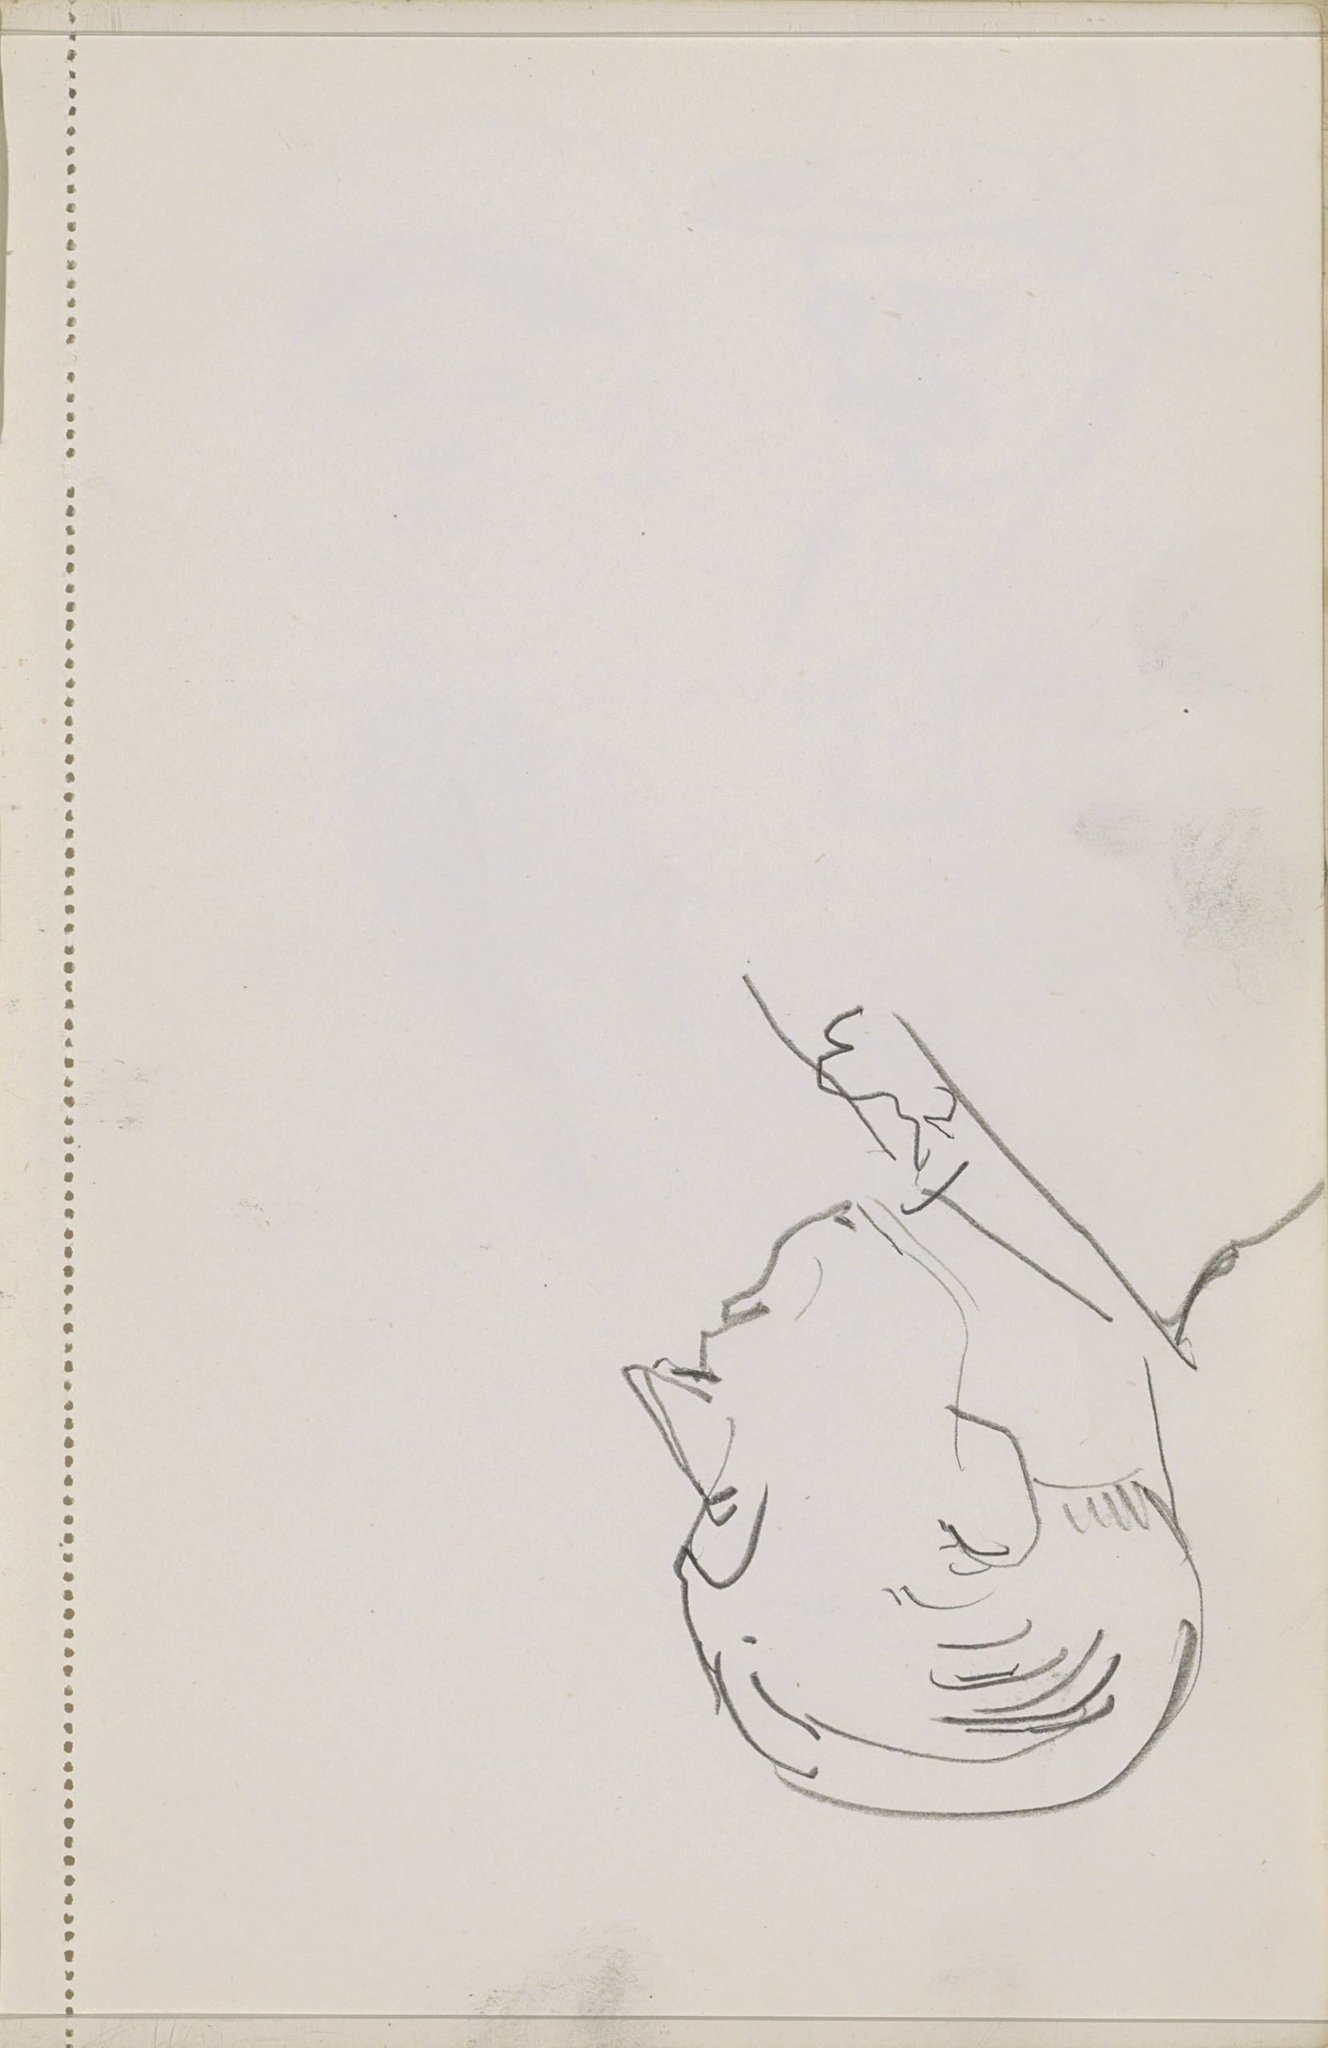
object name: sketchbook leaf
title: Kop van een man met een spitse neus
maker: cornelis vreedenburgh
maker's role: draughtsman, print maker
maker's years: 1880-1946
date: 1890-1946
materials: paper, pencil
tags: head (human)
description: De man heeft het haar achterover gekamd. Blad 10 recto uit een schetsboek met 53 bladen.